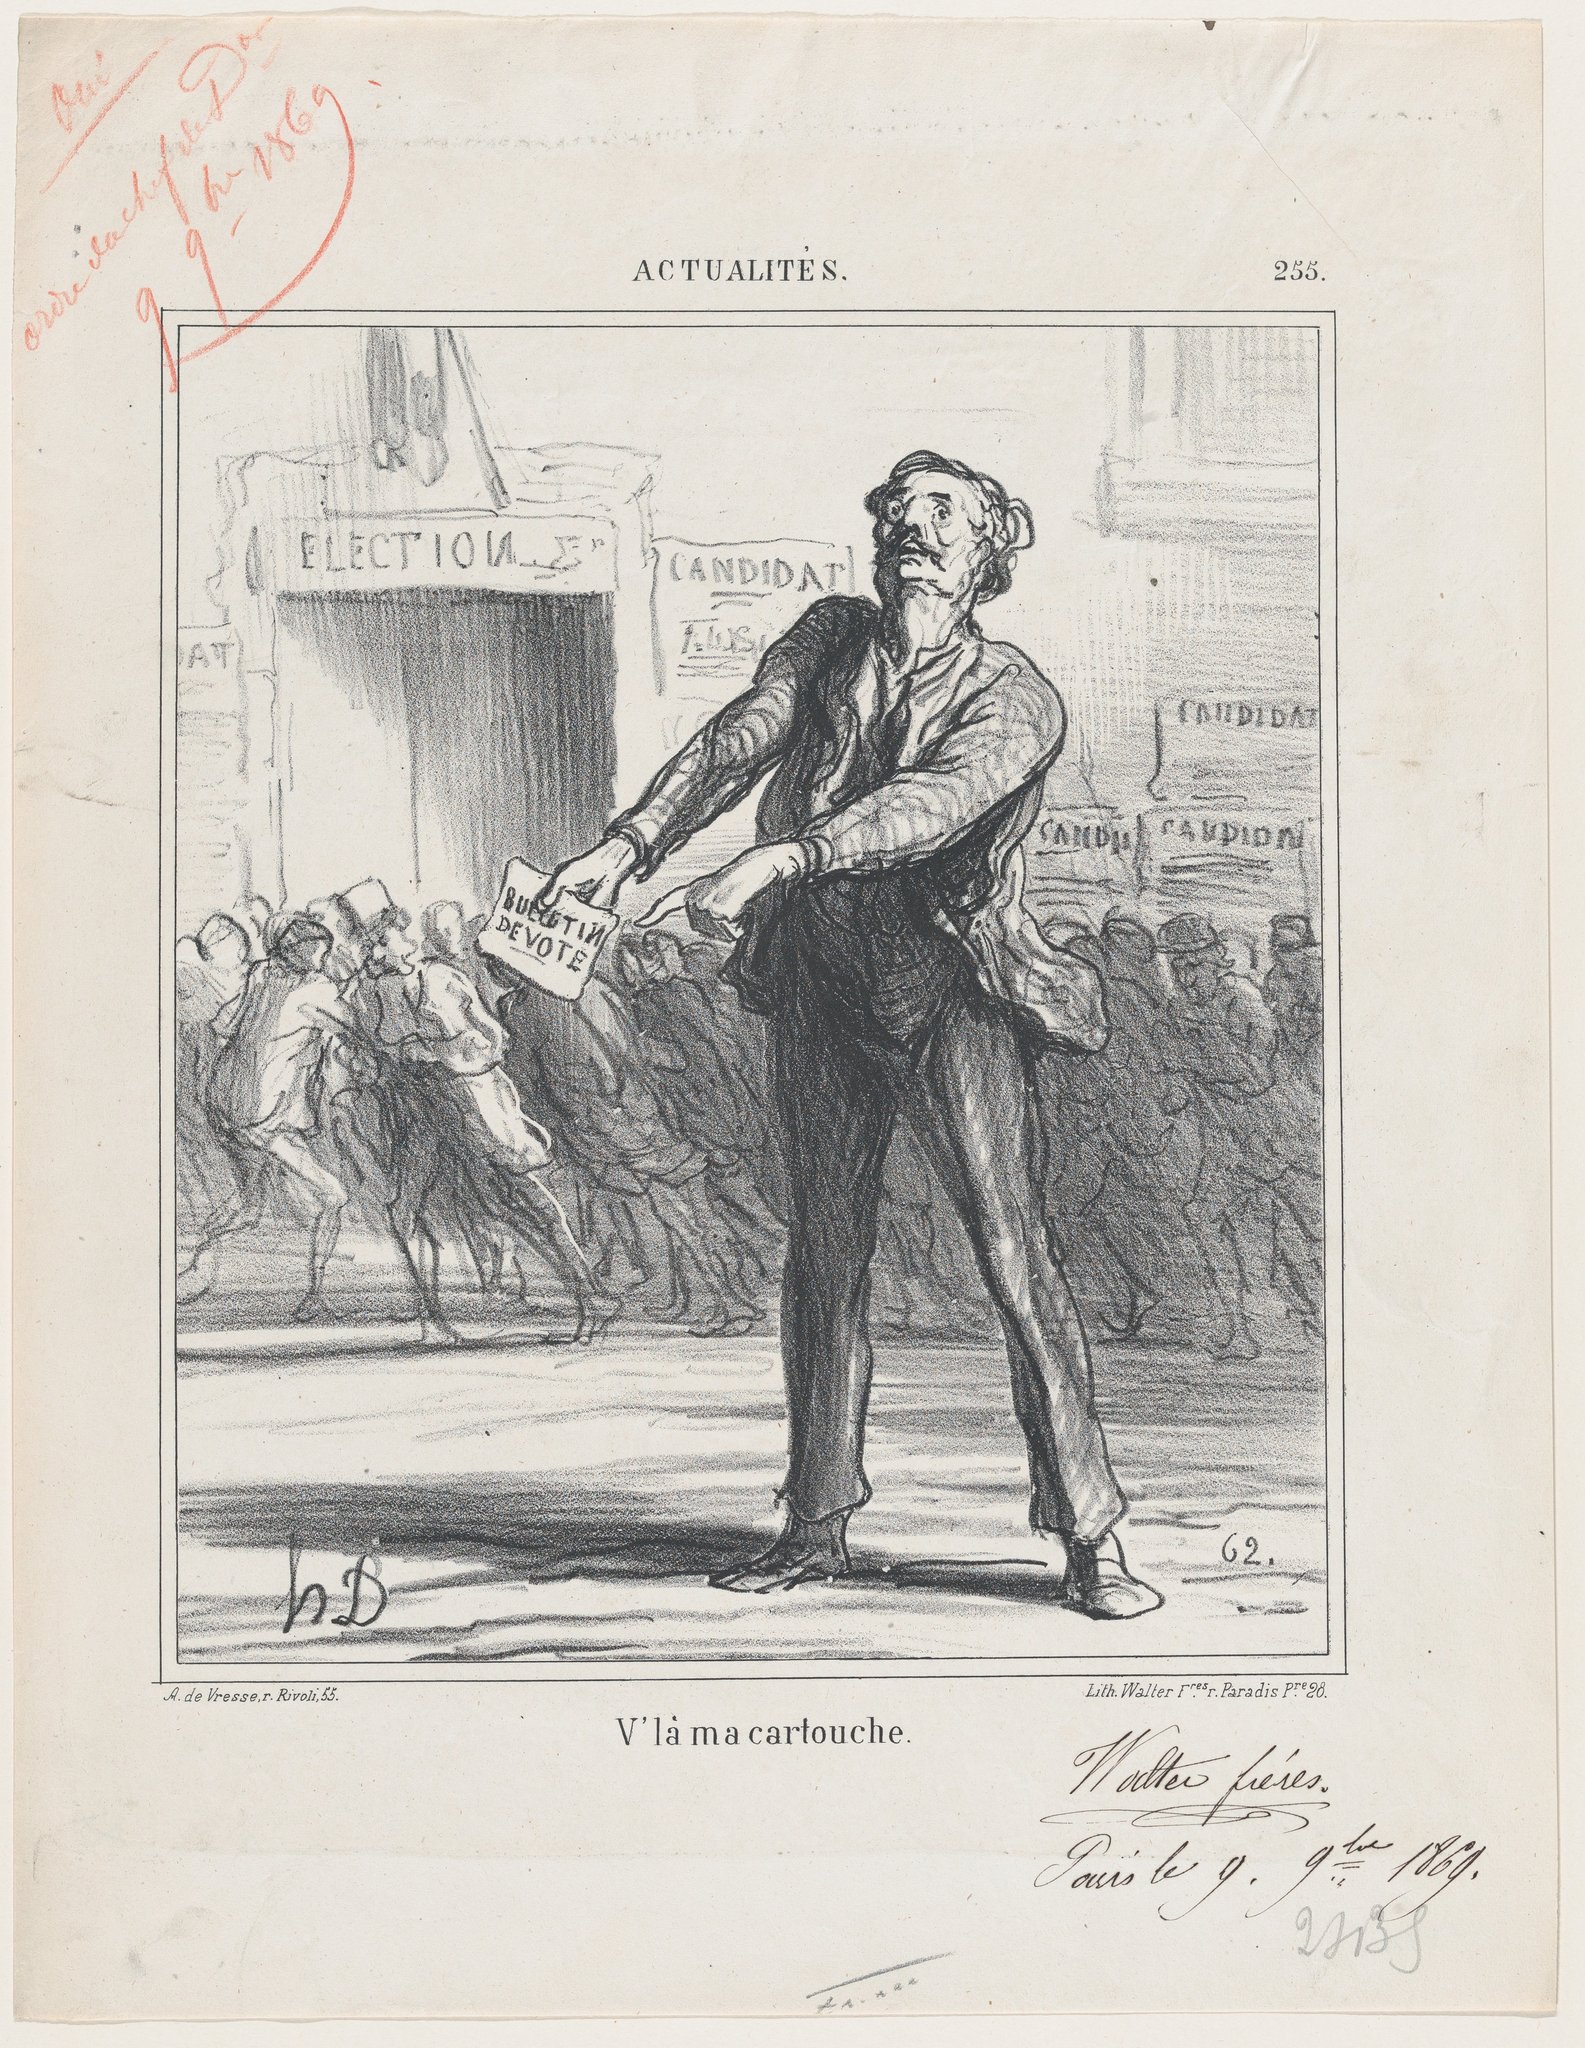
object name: print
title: This is my "bullet," from 'News of the day,' published in Le Charivari, November 20, 1869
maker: honoré daumier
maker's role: artist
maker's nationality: french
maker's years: 1808-1879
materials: paper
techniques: lithograph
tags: satire,men,crowd